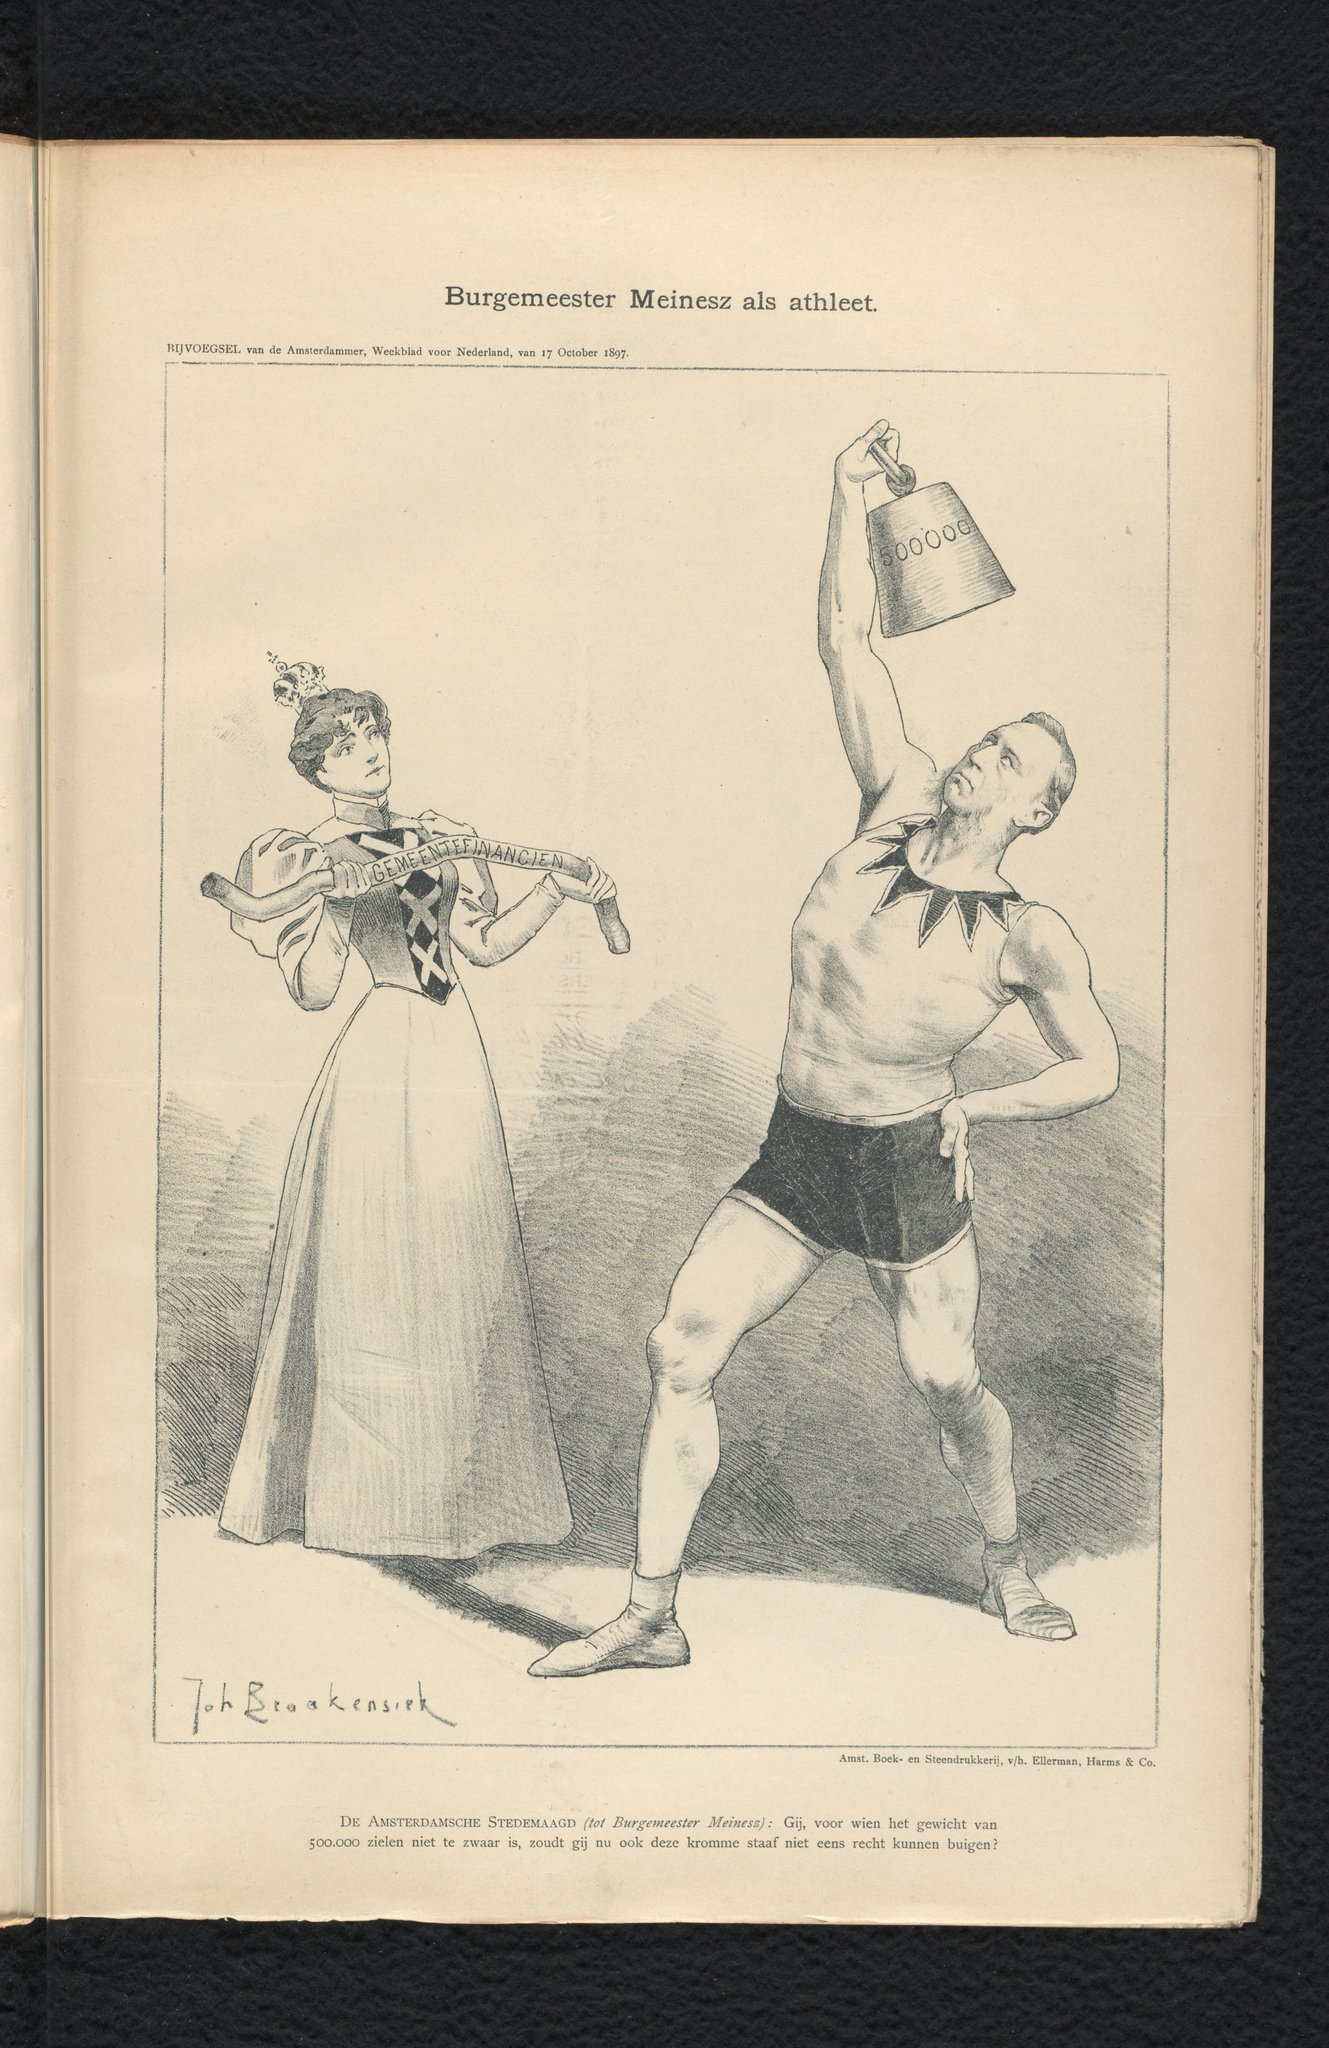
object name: cartoon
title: Burgemeester Meinesz als athleet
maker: johan braakensiek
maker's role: draughtsman, print maker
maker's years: 1858-1940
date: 1897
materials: paper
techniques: lithograph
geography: amsterdam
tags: personification of a city, town-patron(ess), weight lifting, exercise of skill and strength (~ pleasure fair), political caricatures and satires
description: De Amsterdamse stedenmaagd vraagt sterke man burgemeester Vening Meinesz om ook de financiën van de gemeente recht te buigen.